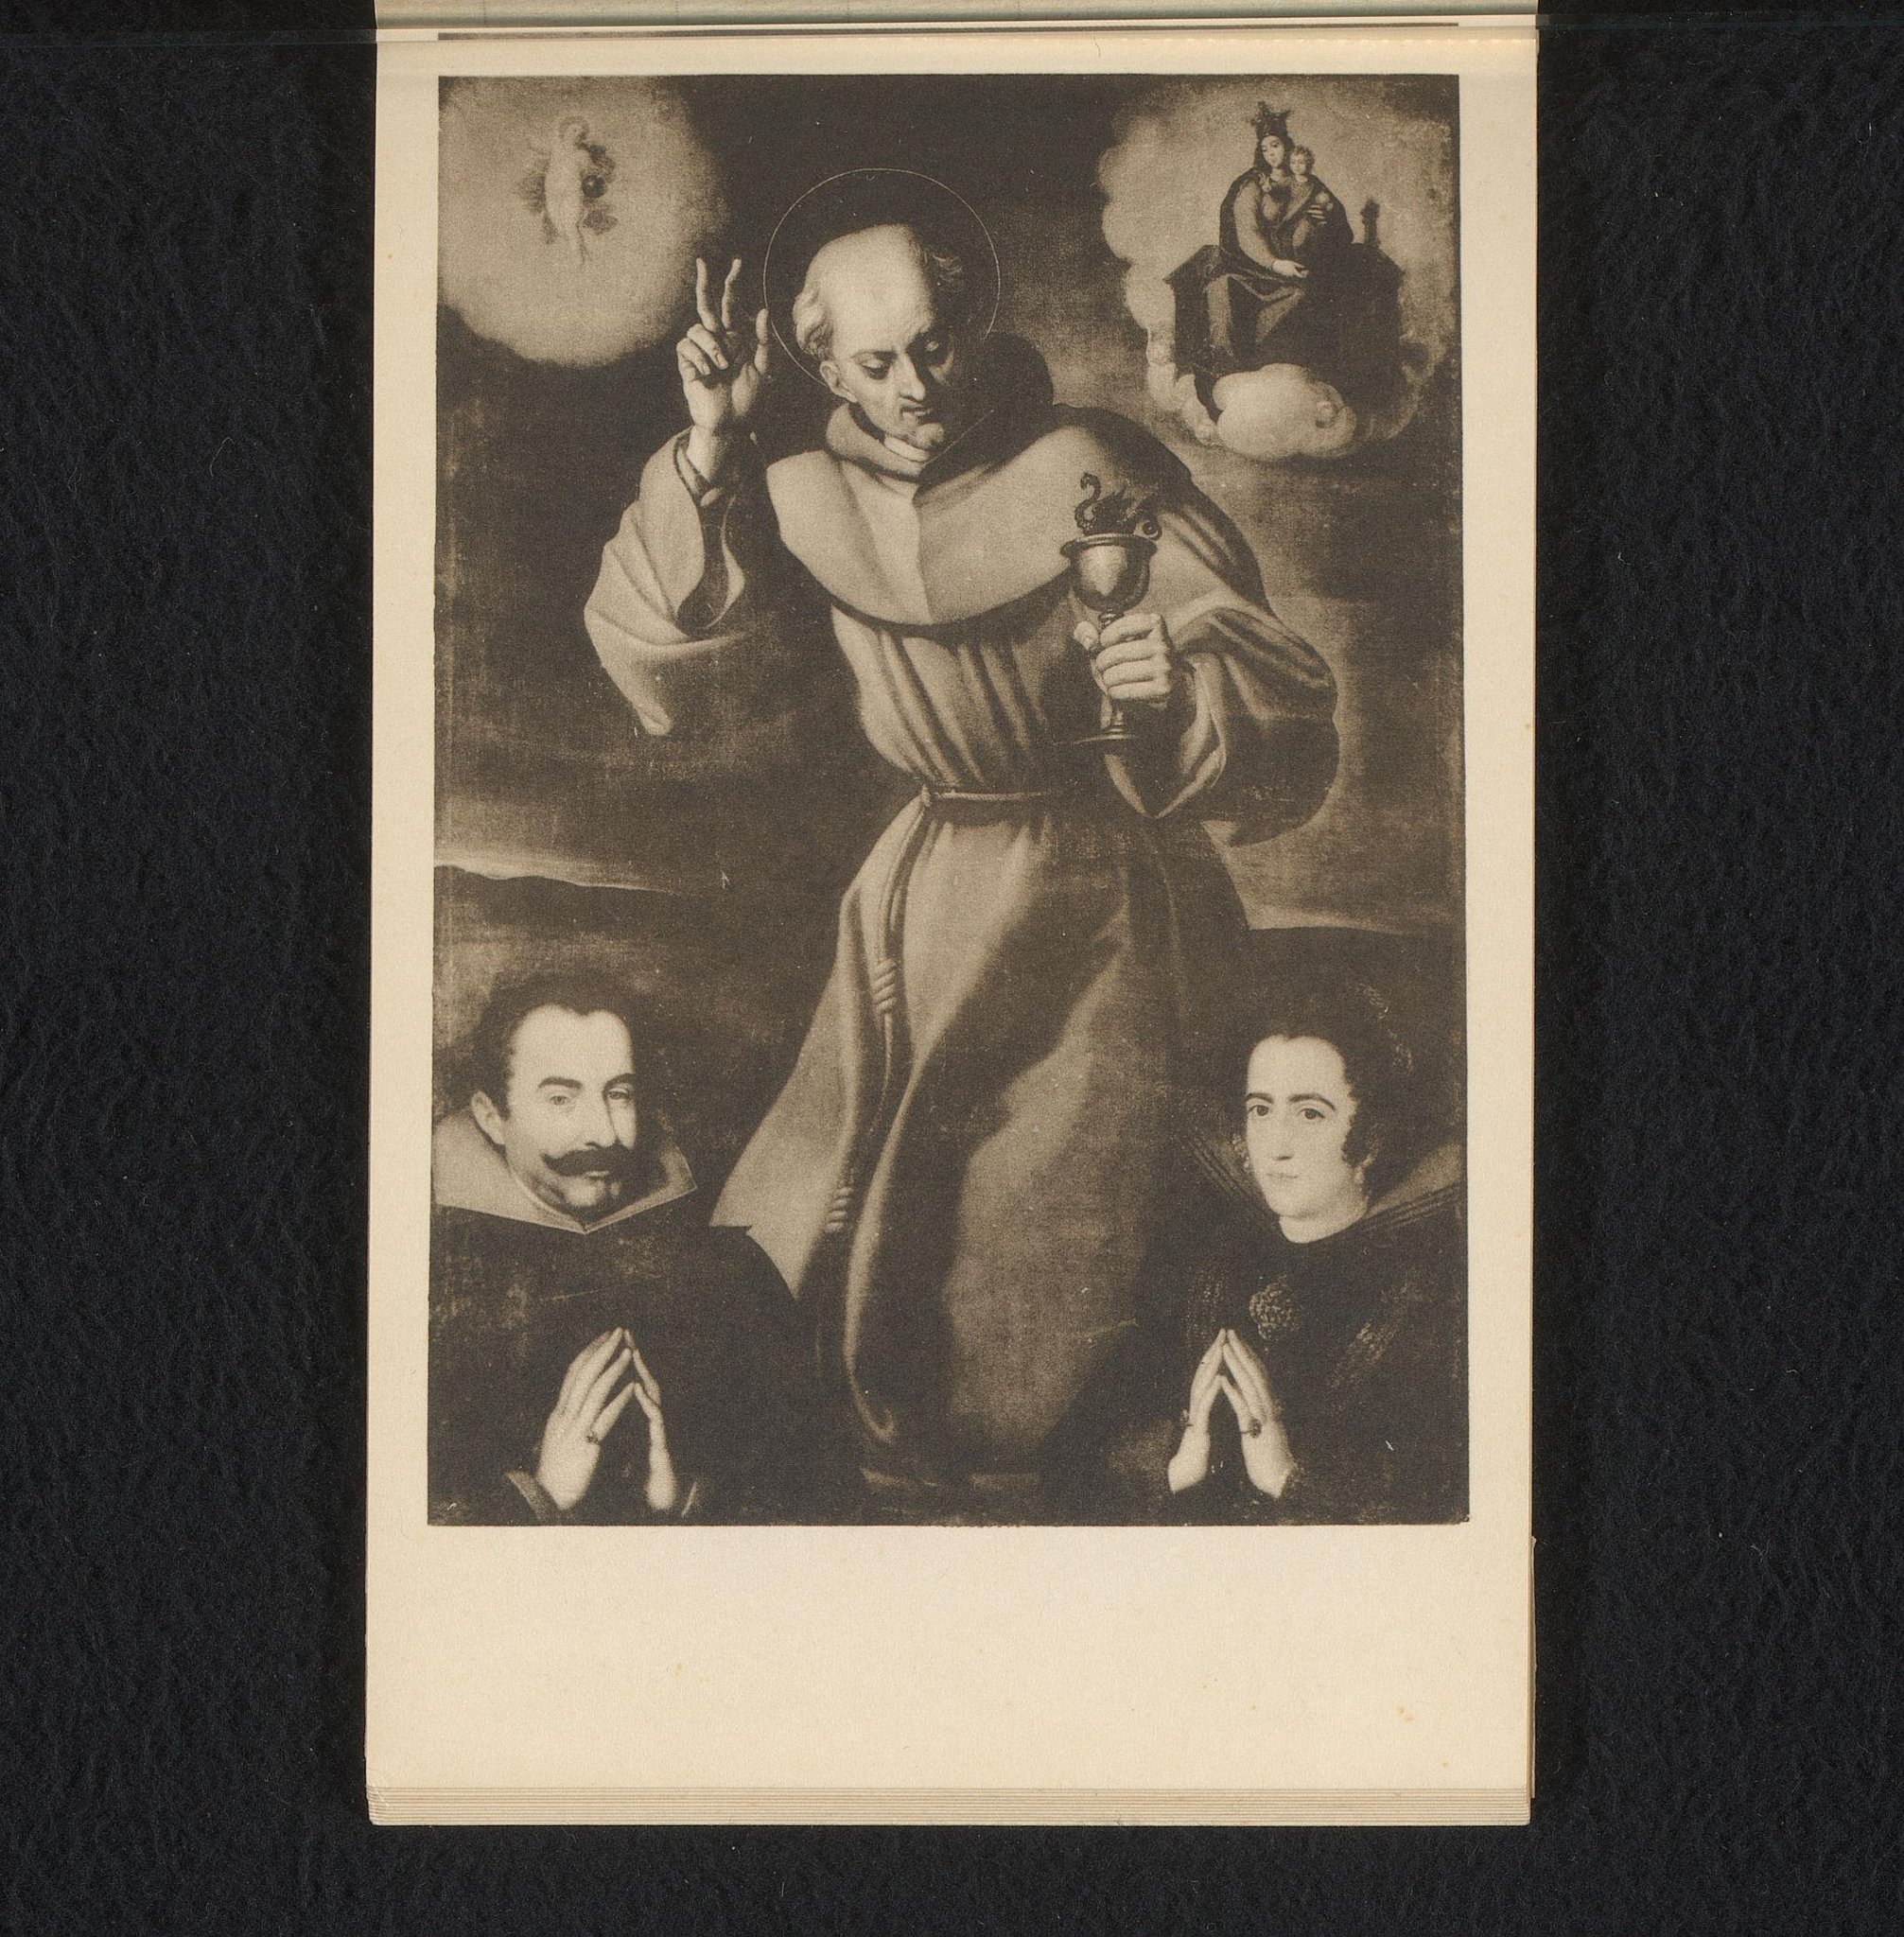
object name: photomechanical print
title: Museo Cerralbo. Madrid. San Jacobo de la Marca con dos figuras orantes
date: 1924-1930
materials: cardboard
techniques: photograph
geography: madrid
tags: permanent exhibition, museum, picture, painting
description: Prentbriefkaart maakt deel uit van een album.